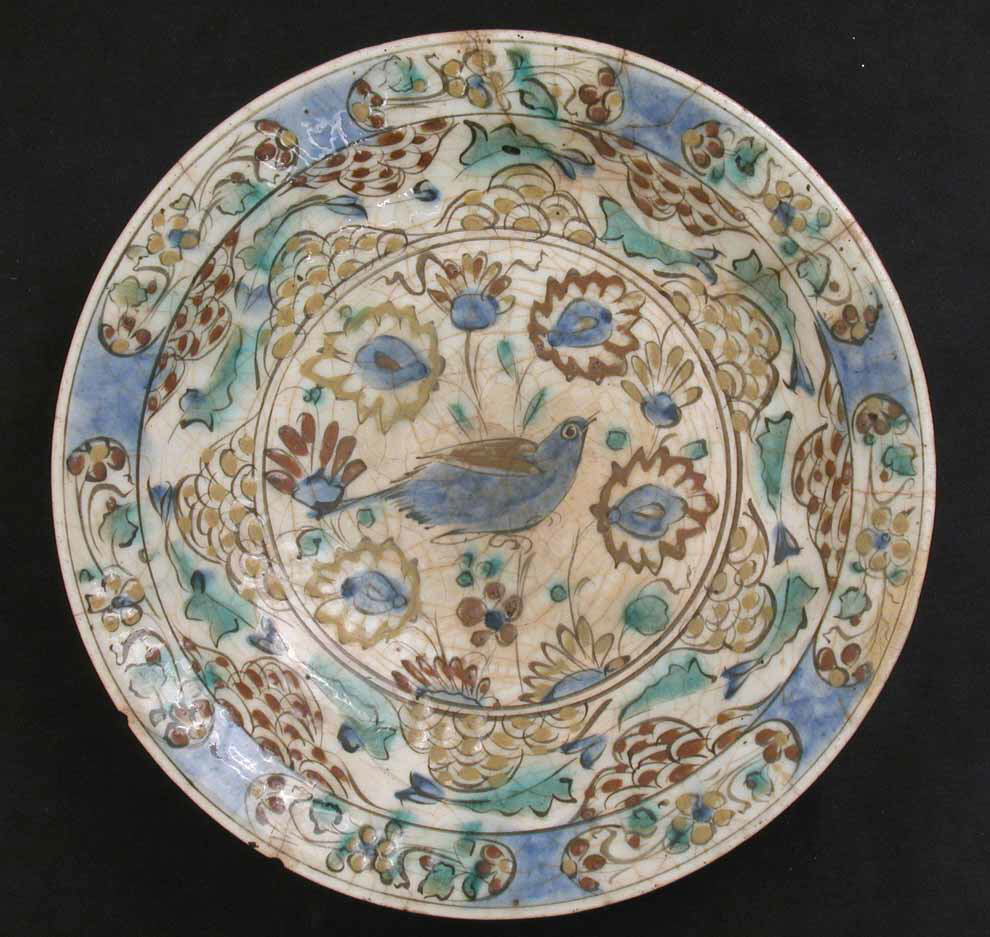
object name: dish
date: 1601-1700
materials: glaze, stonepaste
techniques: painting, polychrome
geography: iran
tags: birds,flowers